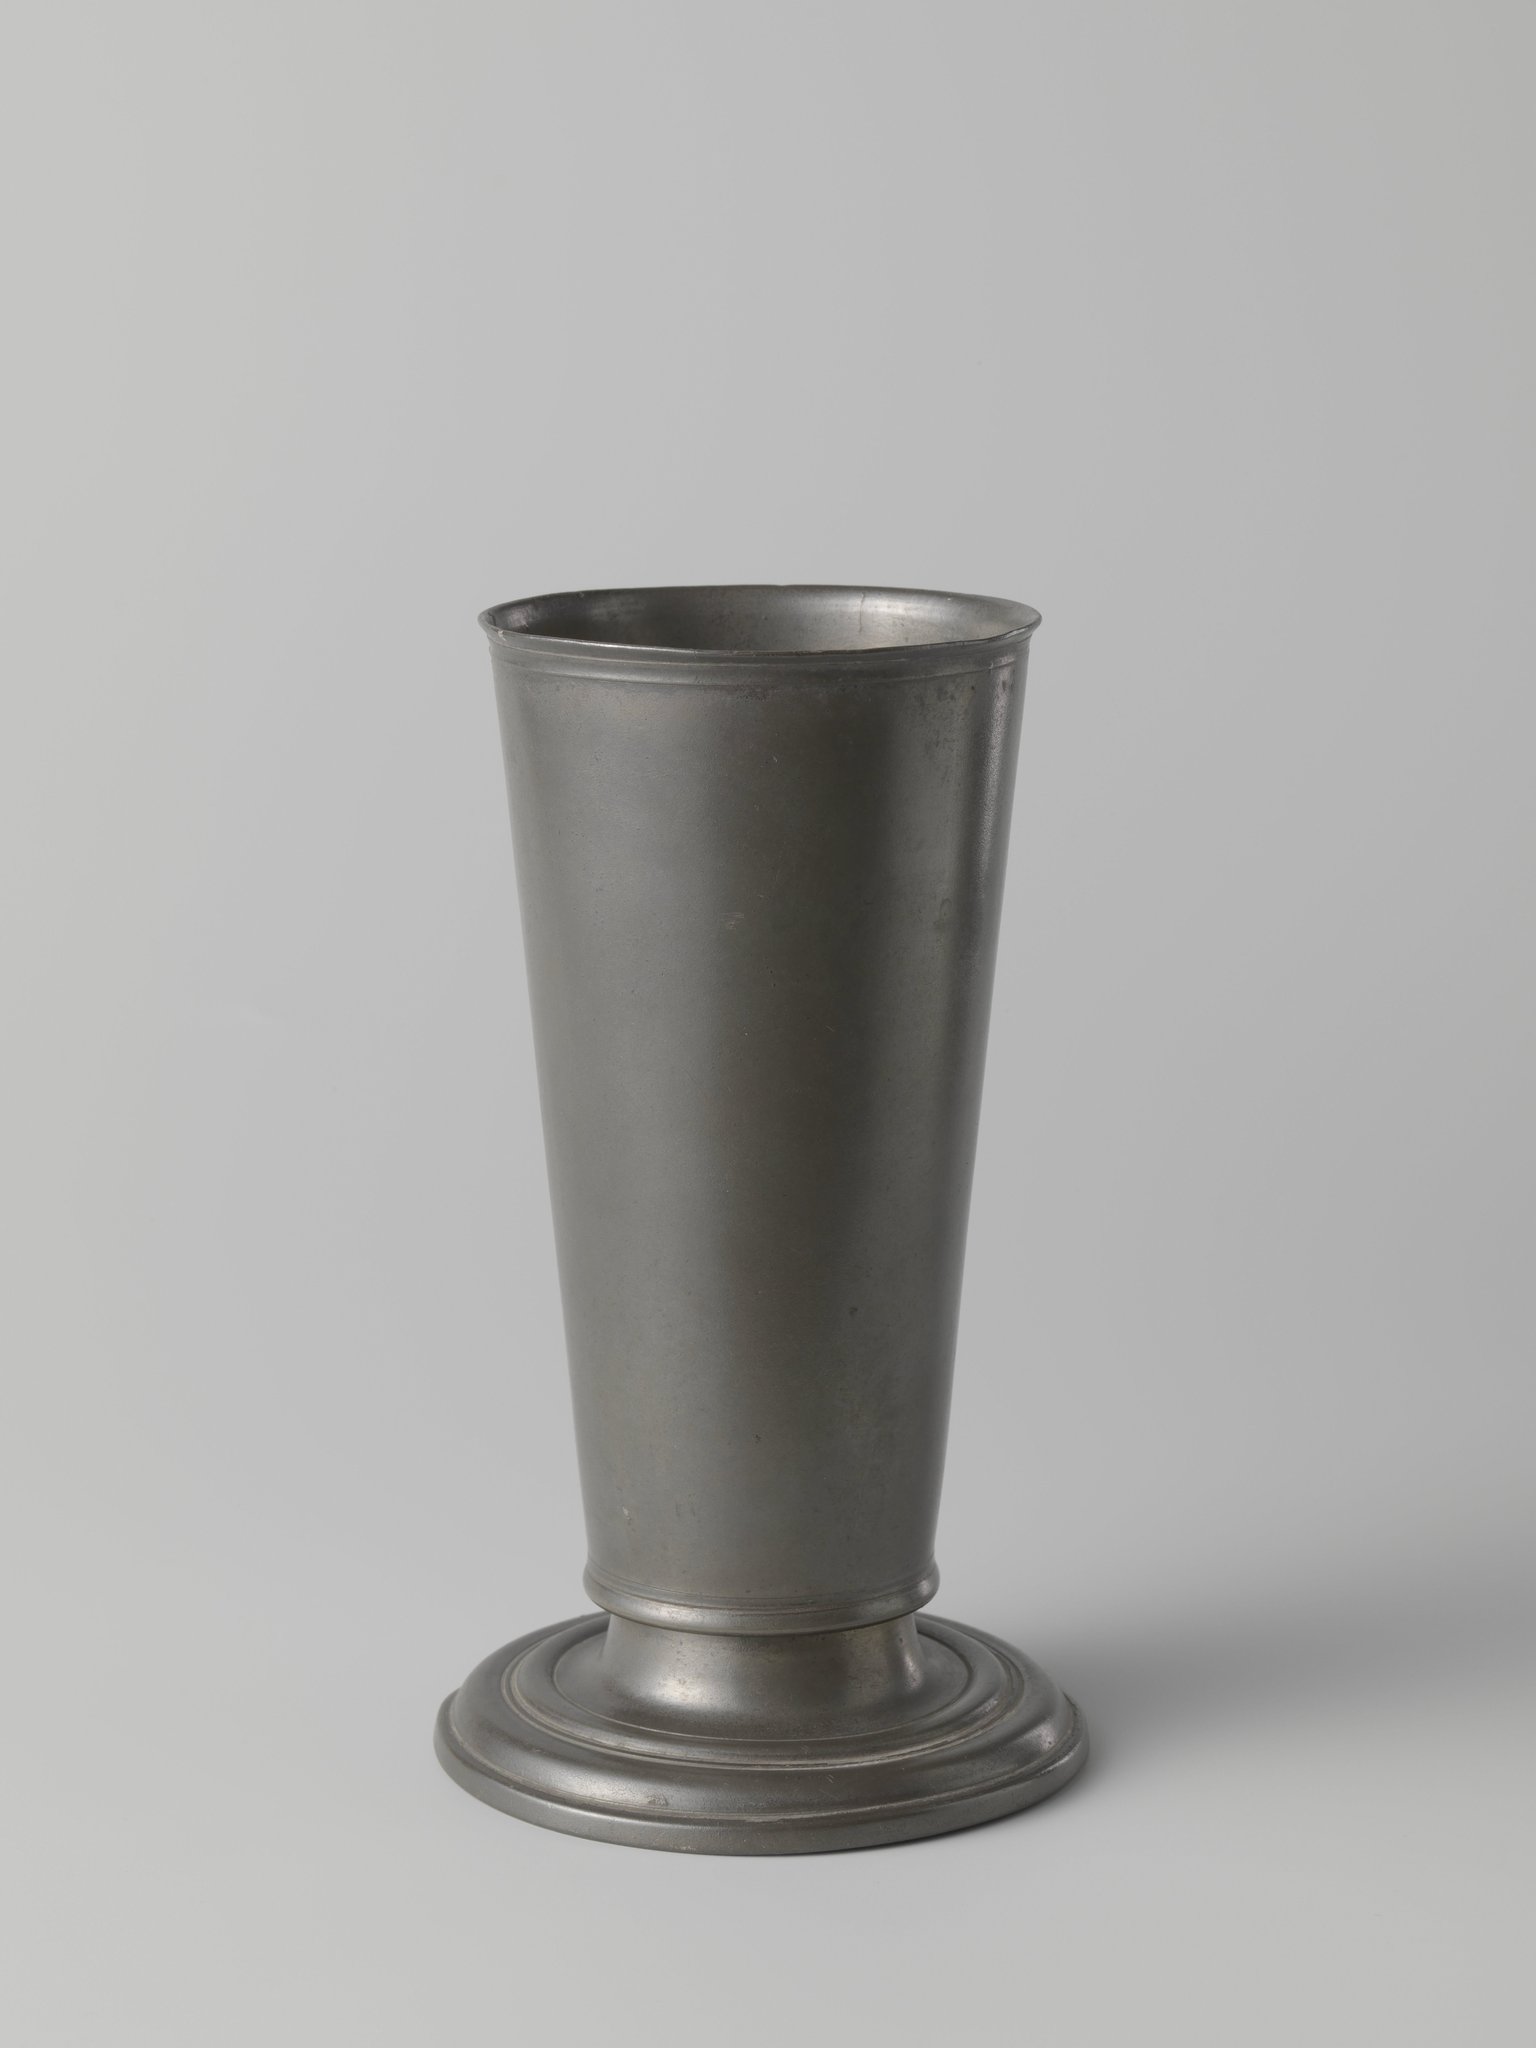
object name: communion cup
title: Communion jug and two cups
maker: Anonymous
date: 1700-1750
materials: tin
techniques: casting, turning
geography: northern netherlands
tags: westerkerk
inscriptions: quality mark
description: The plain jug and cups on view here were used in the Westerkerk in Amsterdam, one of four churches built in the city for Protestant worship during the first half of the 17th century. Protestants repudiated what they felt was the sinful, ostentatious display of wealth in the Catholic Church. They favoured highly austere objects even for the solemn celebration of communion.